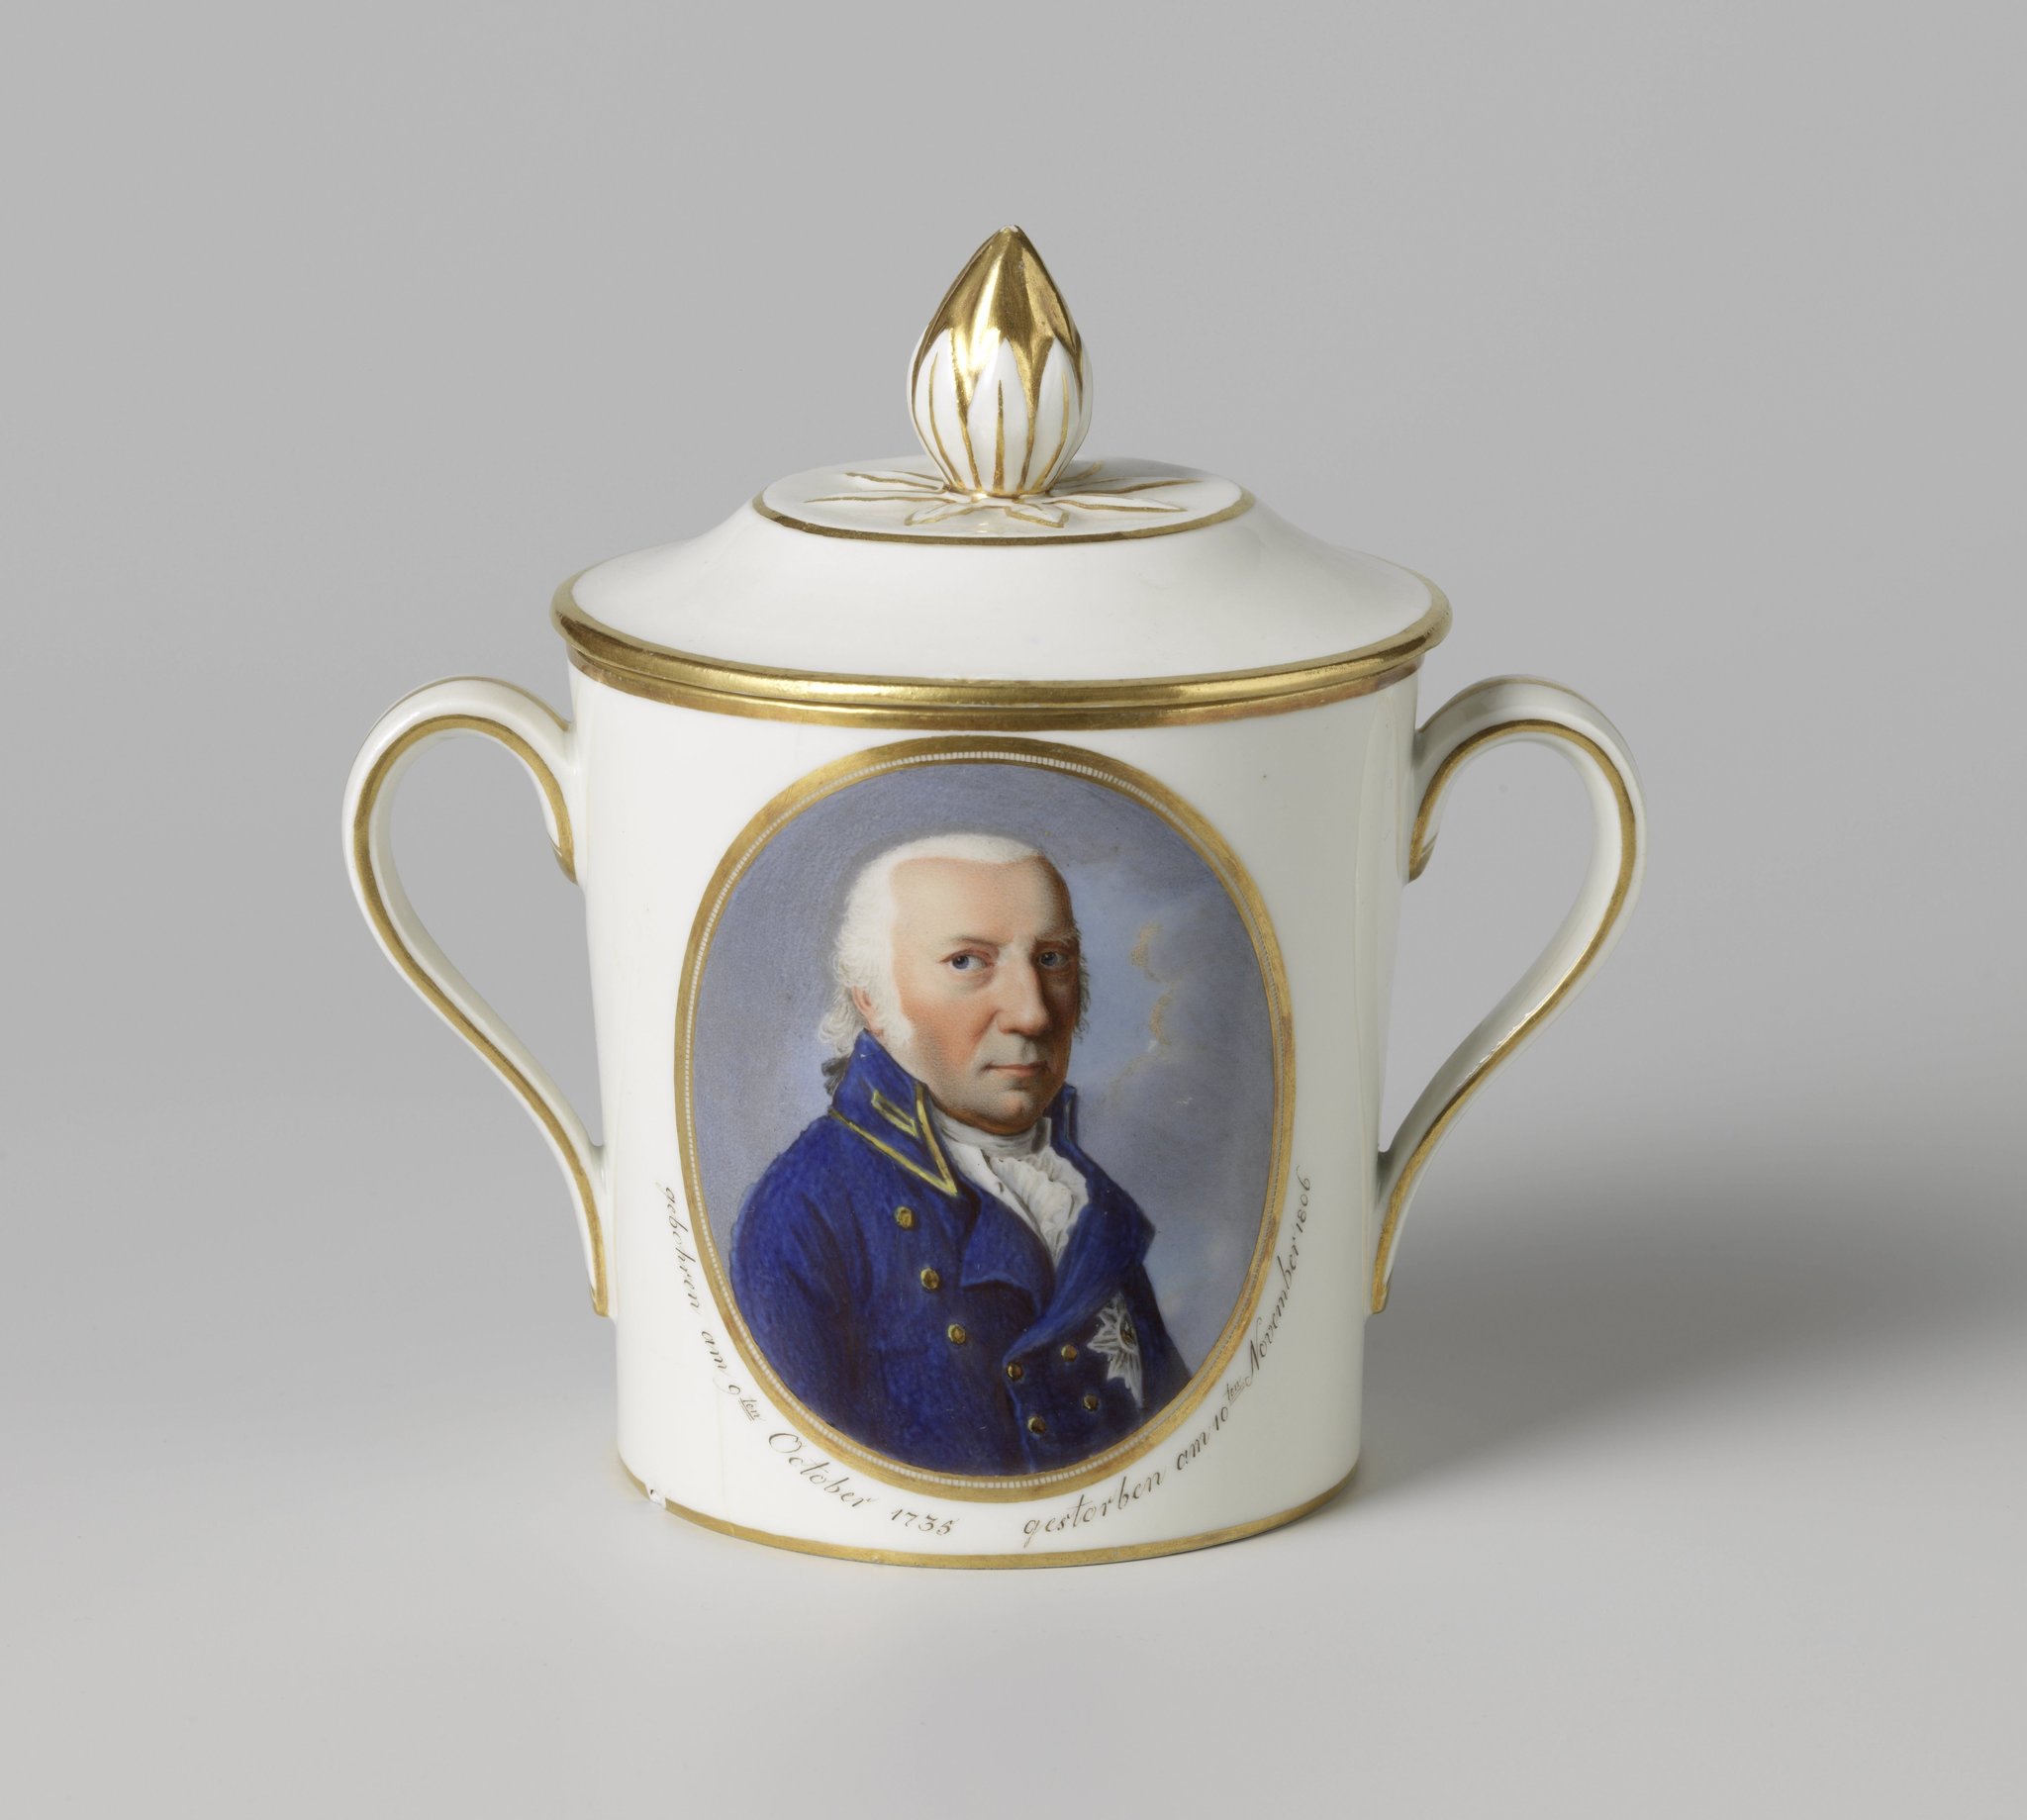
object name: covered cup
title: Covered cup with the portrait of Karel Willem Ferdinand van Brunswijk-Wolfenbüttel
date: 1806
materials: glaze, gold, paint, porcelain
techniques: firing, forming, gilding, turning, vitrification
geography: furstenberg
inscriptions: inscription: ‘NUNQUAM RETRORSUM’, inscription: ‘GEBOHREN AM 9ten OCTOBER 1735/ GESTORBEN AM 10ten NOVEMBER 1806’, mark: ‘F/ 5/ D5../ X’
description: Cup and cover with a portrait of Karl II Wilhelm Ferdinand as Duke of Brunswickand Lüneburg. Porcelain. Fürstenberg, c. 1806. J.G.A.N. de Vries bequest, 1925.